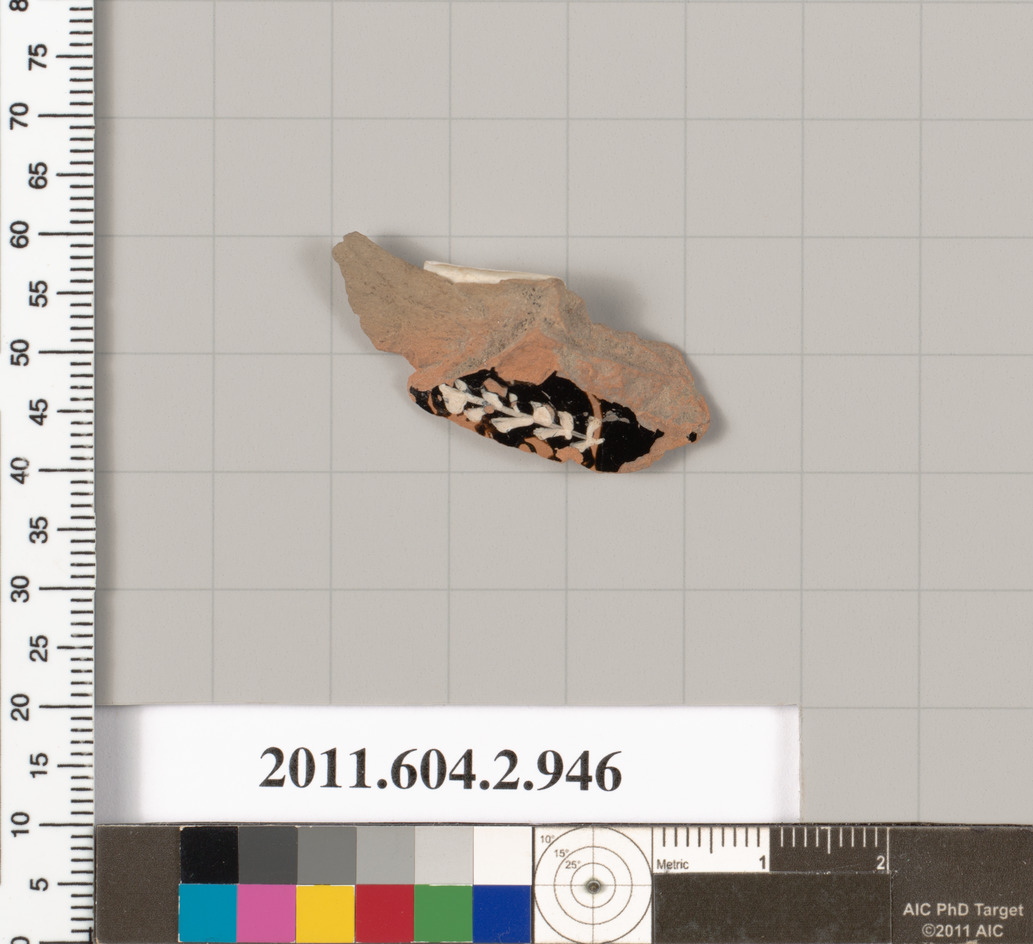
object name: oinochoe fragment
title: Terracotta fragment of an oinochoe (jug)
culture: greek, attic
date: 460-440 BCE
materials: terracotta